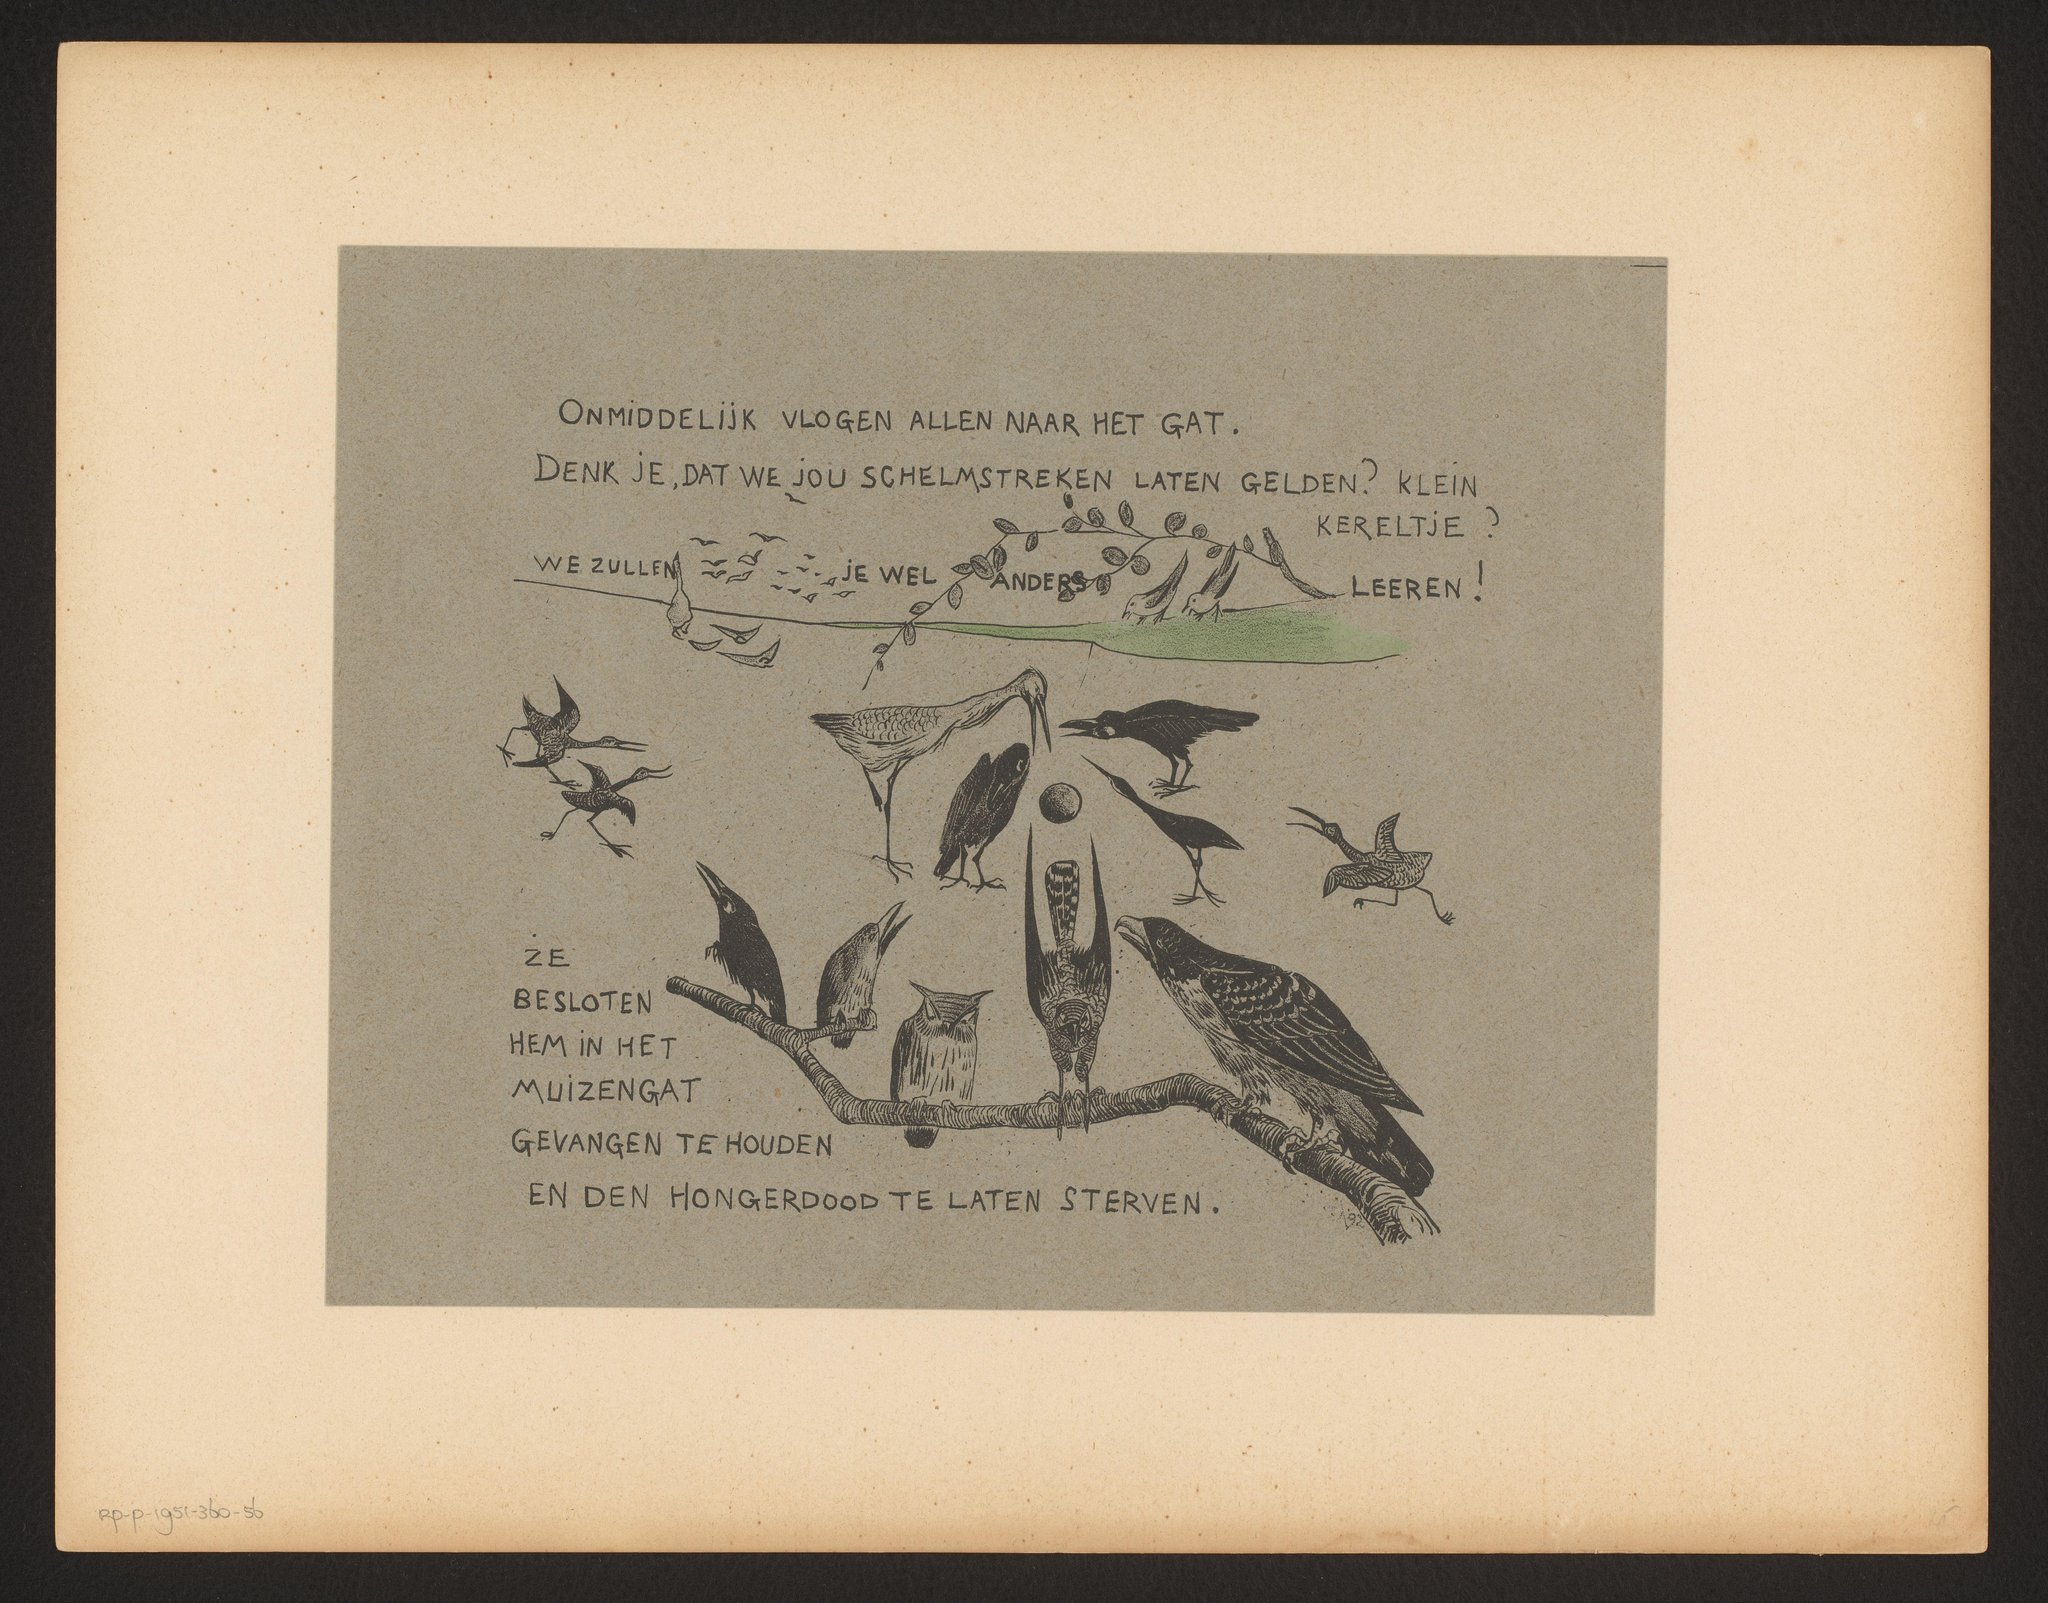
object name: print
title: Tekstblad met diverse vogelsoorten bij het muizenhol waarin de winterkoning verdween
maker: theo van hoytema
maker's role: draughtsman, painter, print maker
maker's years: 1863-1917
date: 1892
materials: paper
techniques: hand coloring, lithograph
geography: the hague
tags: song-birds: wren, groups of birds, pit, hole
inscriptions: date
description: Zowel tekst als afbeelding zijn gelithografeerd.